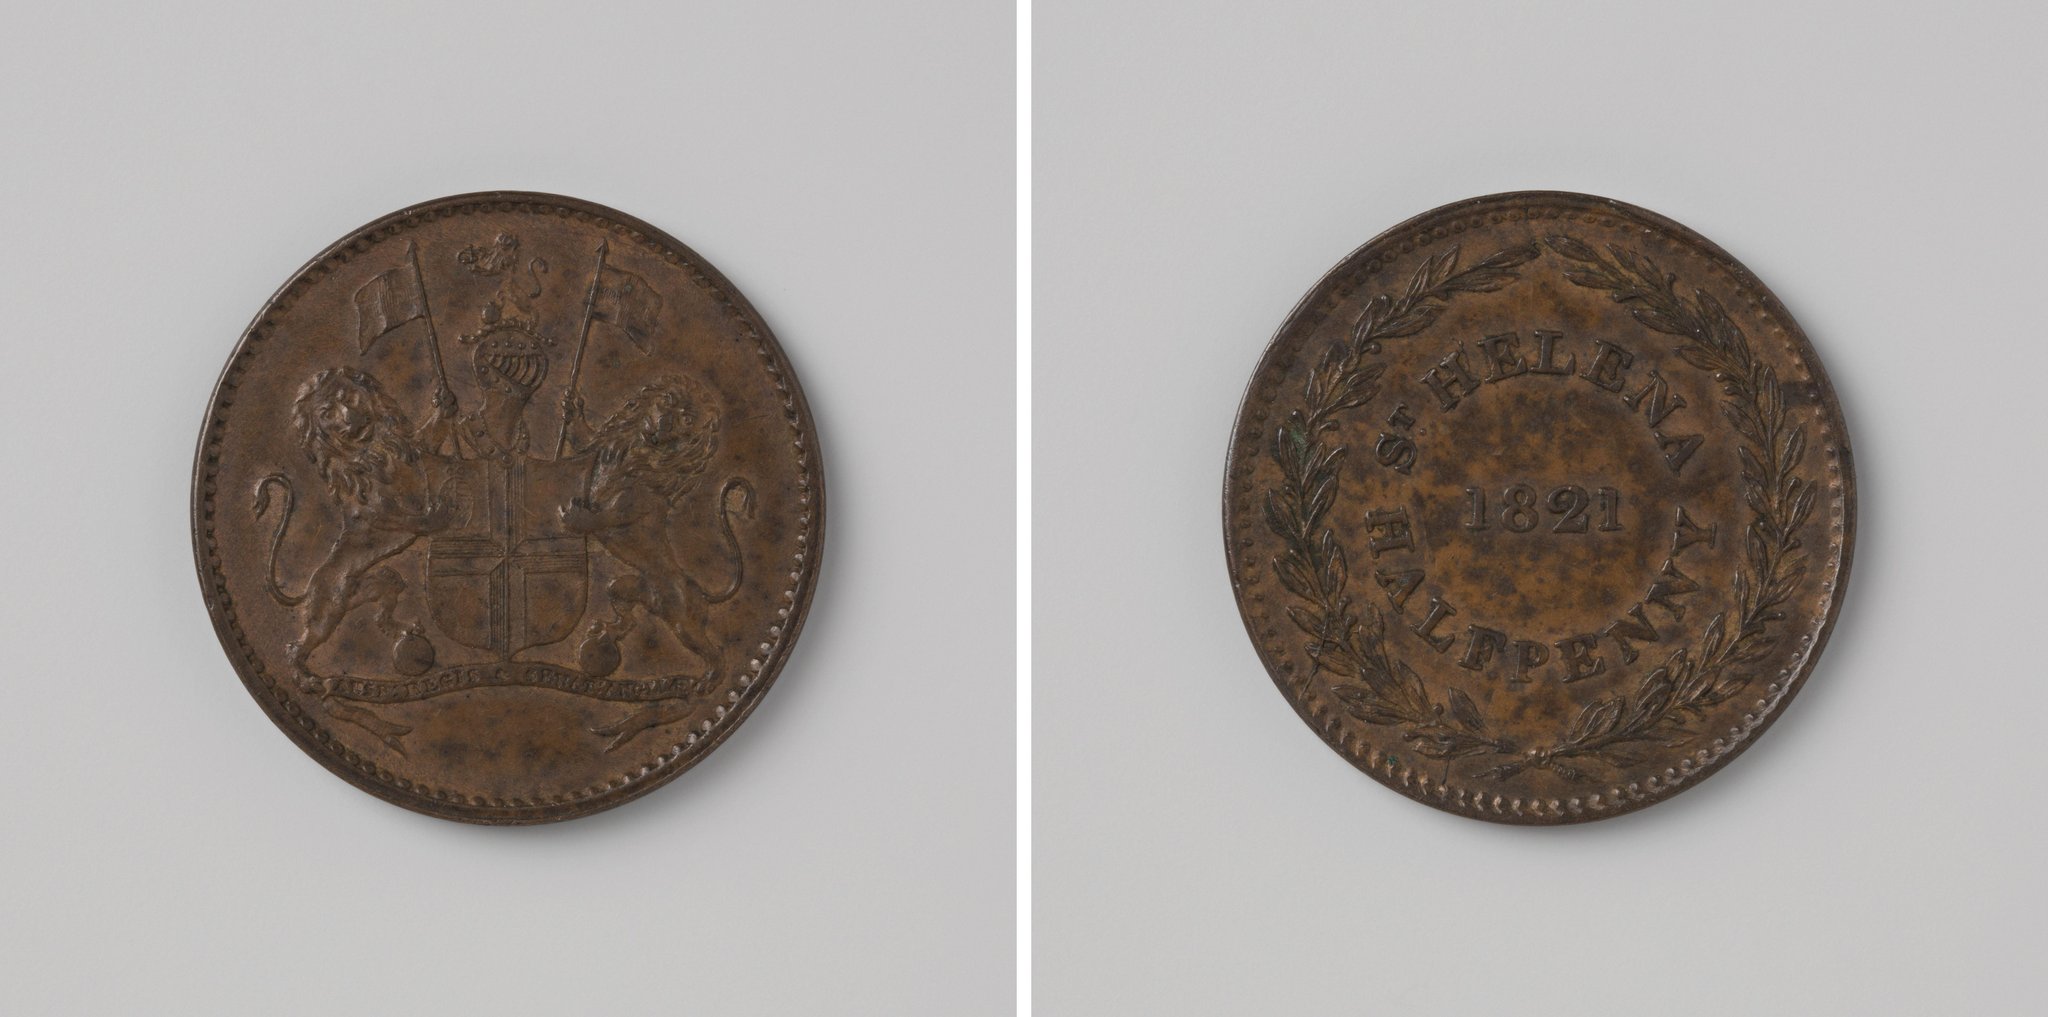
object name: coin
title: Munt van een halve penny van Sint Helena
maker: Anonymous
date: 1821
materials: bronze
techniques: striking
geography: england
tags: sint-helena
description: Voorzijde: twee leeuwen, elk met vaandel, tillen gezamelijk gehelmd wapenschild boven wimpel met opschrift. Keerzijde: jaartal binnen omschrift en lauwerkrans